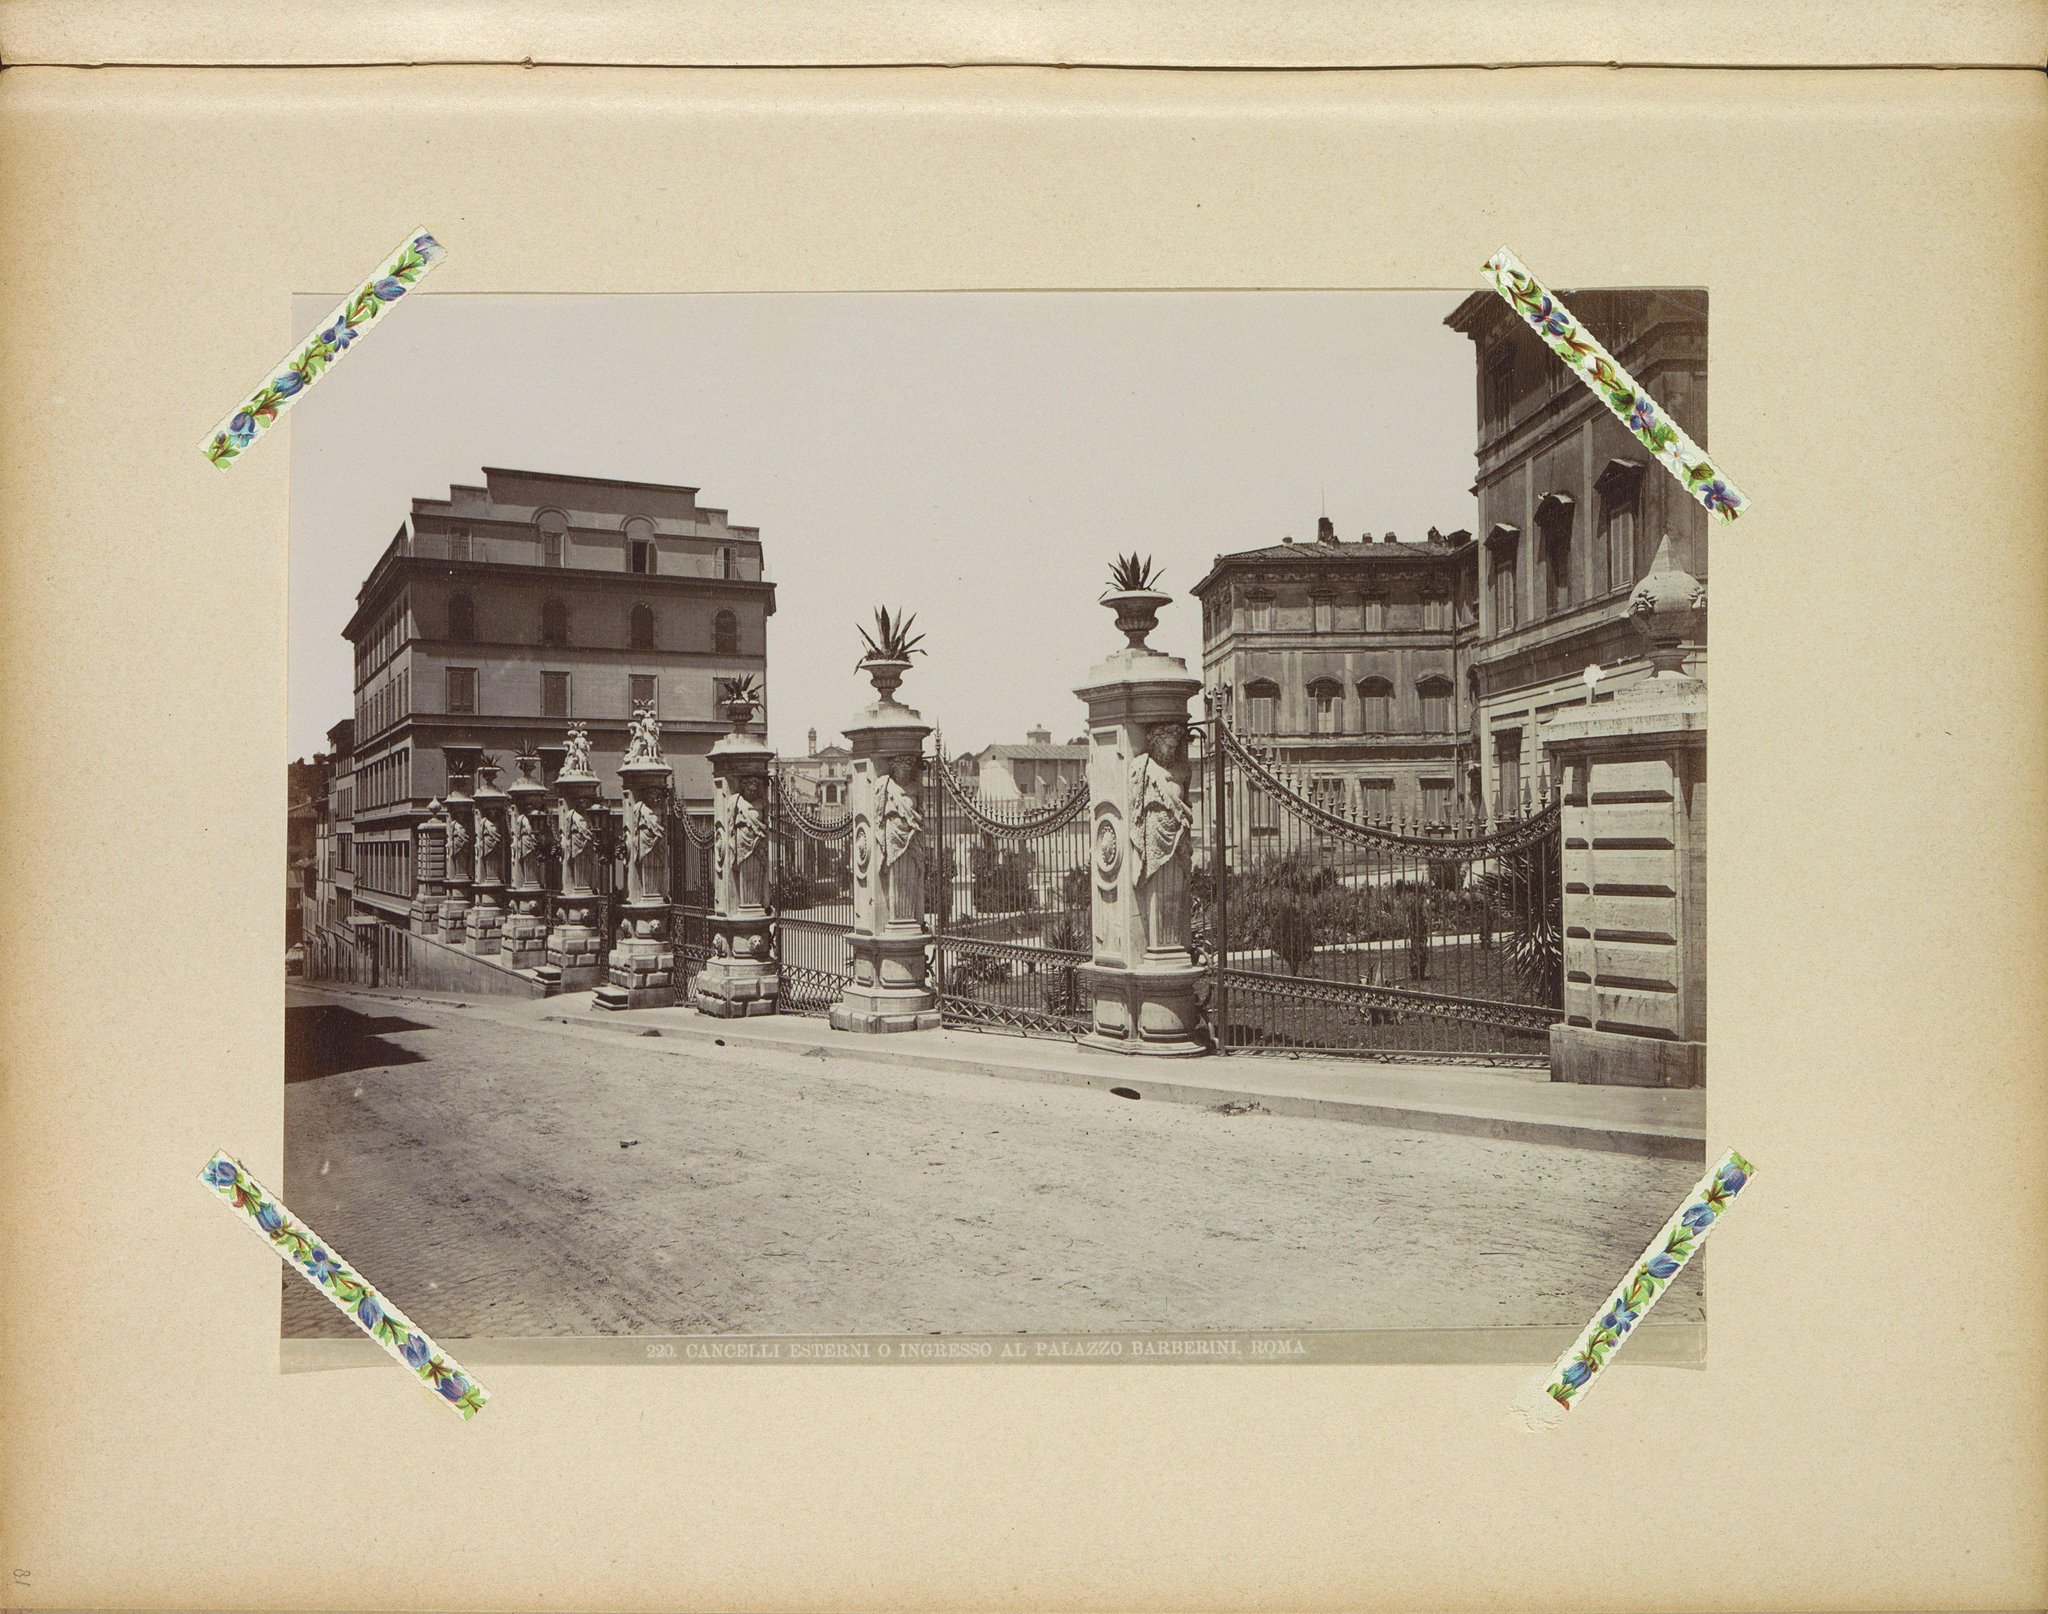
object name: photograph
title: Cancelli esterni o ingresso al Palazzo Barberini. Roma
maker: Anonymous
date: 1860-1900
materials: photographic support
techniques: albumen print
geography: rome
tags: fence, wall, paling, palace, gate, entrance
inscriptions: number: ‘220’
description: Onderdeel van Fotoalbum met opnames van bezienswaardigheden in Italiaanse steden en van kunstwerken.